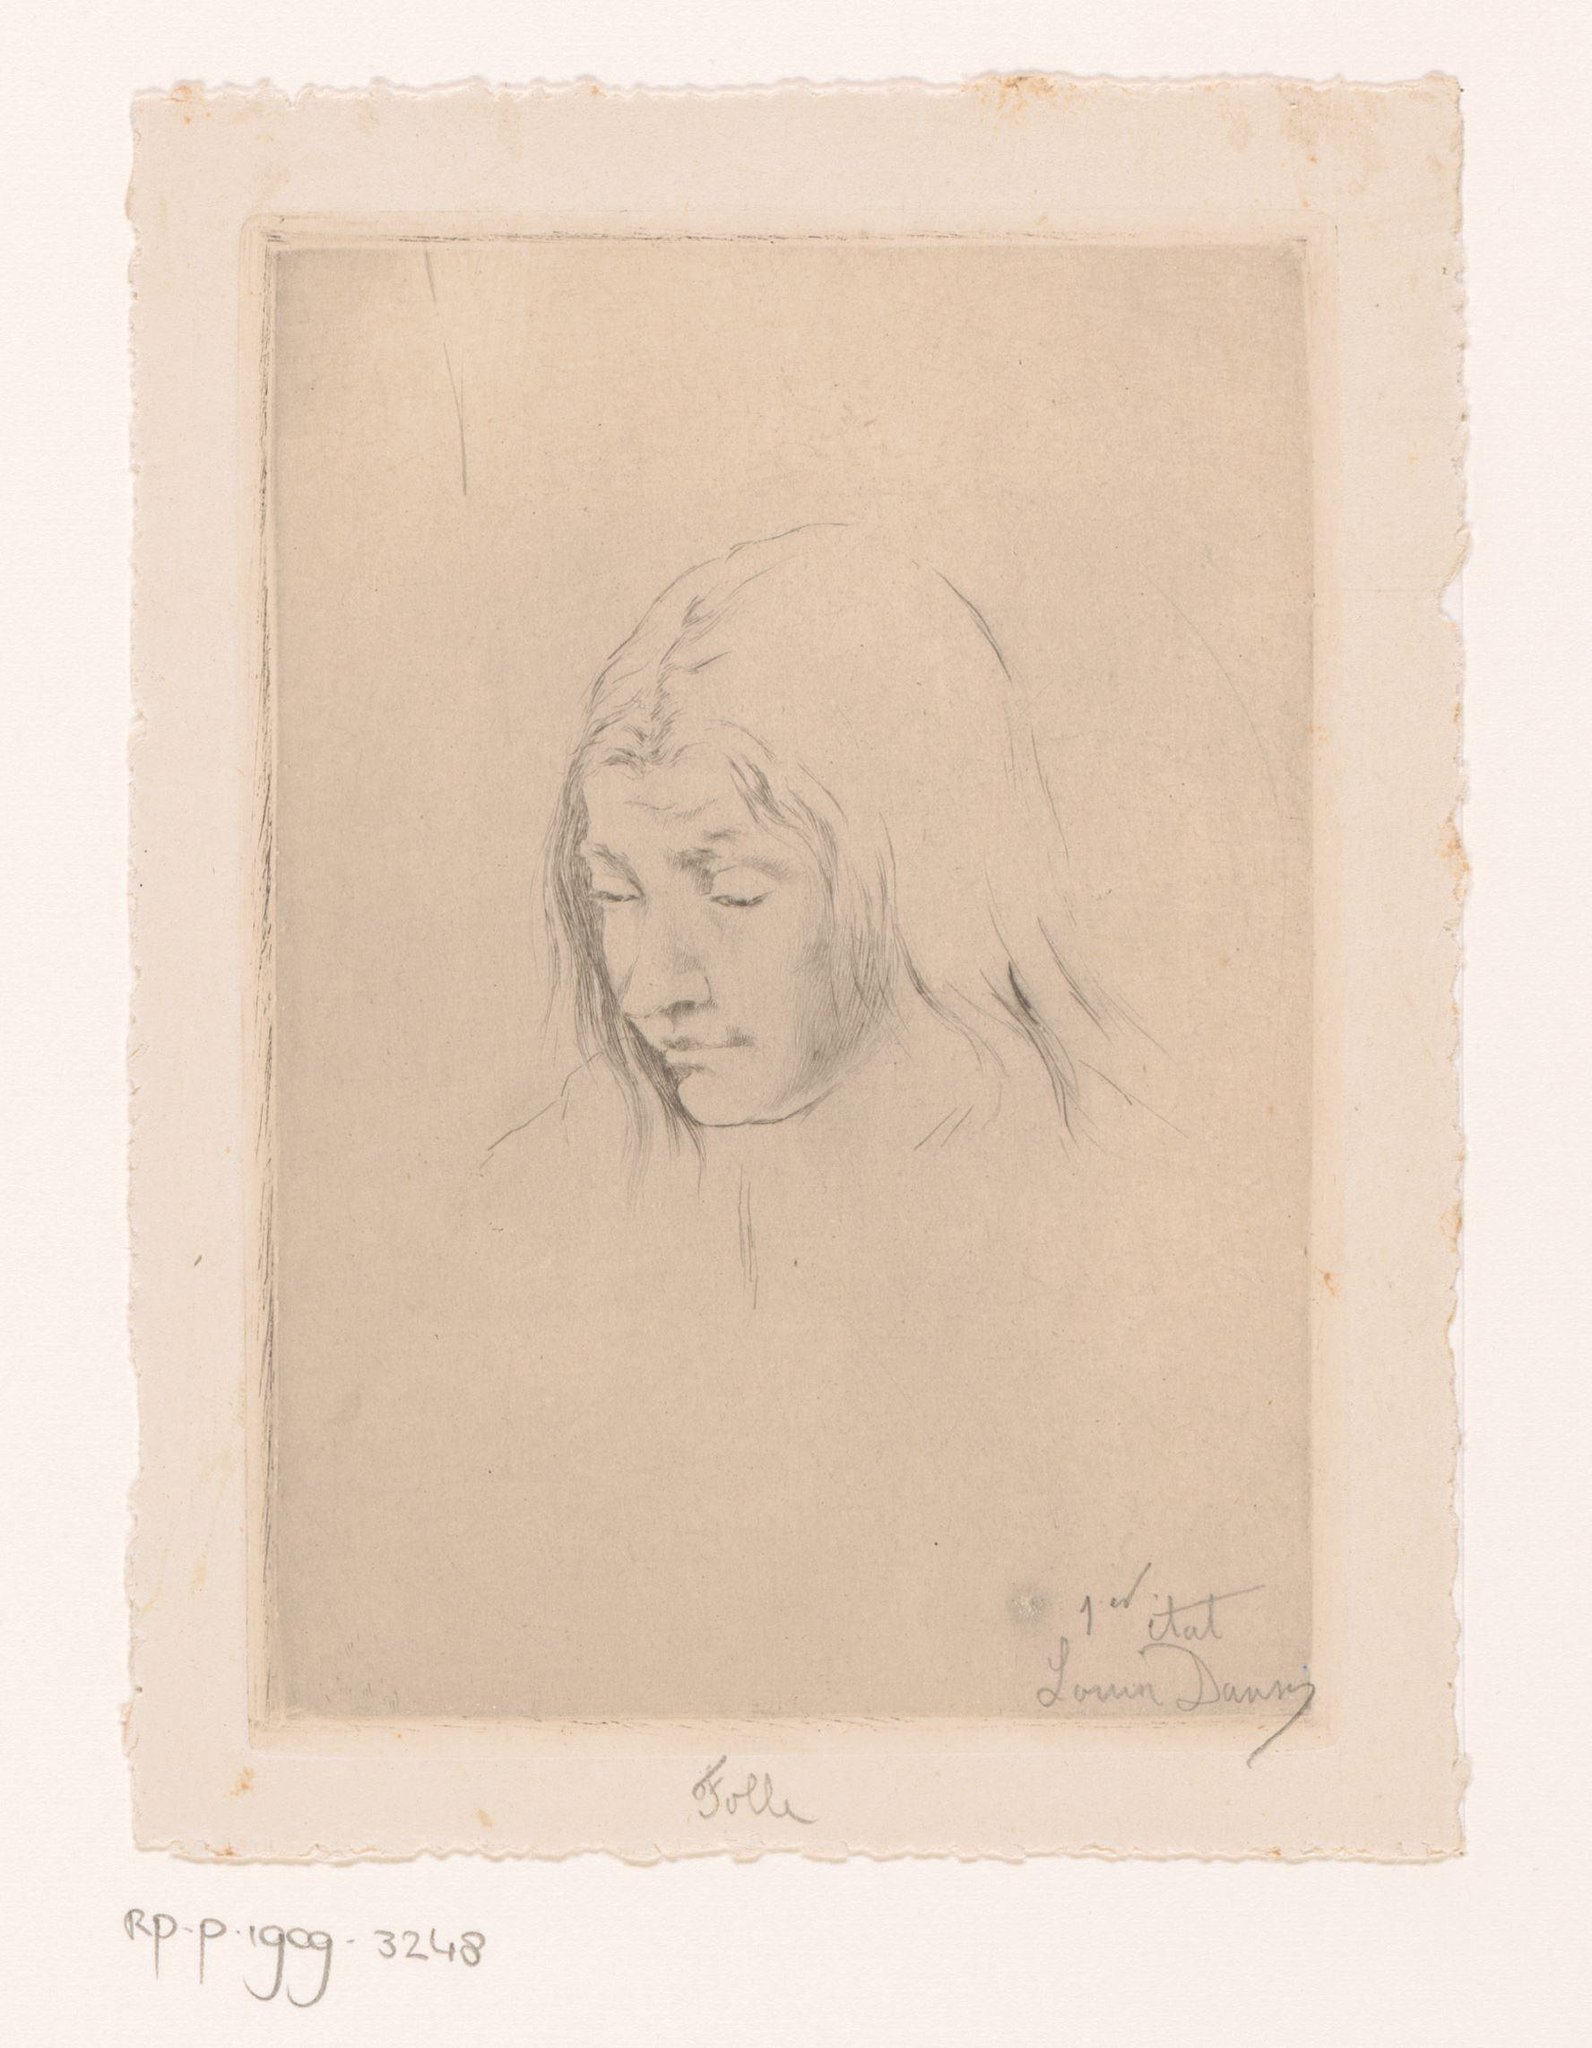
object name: print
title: Gek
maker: louise danse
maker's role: painter, print maker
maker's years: 1867-1948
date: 1890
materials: paper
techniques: etching, intaglio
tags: anonymous historical person portrayed alone - bb - woman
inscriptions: annotation: ‘1er état’, collector's mark: Lugt 2228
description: RP-P-1909-3249 is dezelfde prent. Hoewel die ook het opschrift "1er état" (eerste staat) heeft, lijkt deze afdruk toch een eerdere staat.